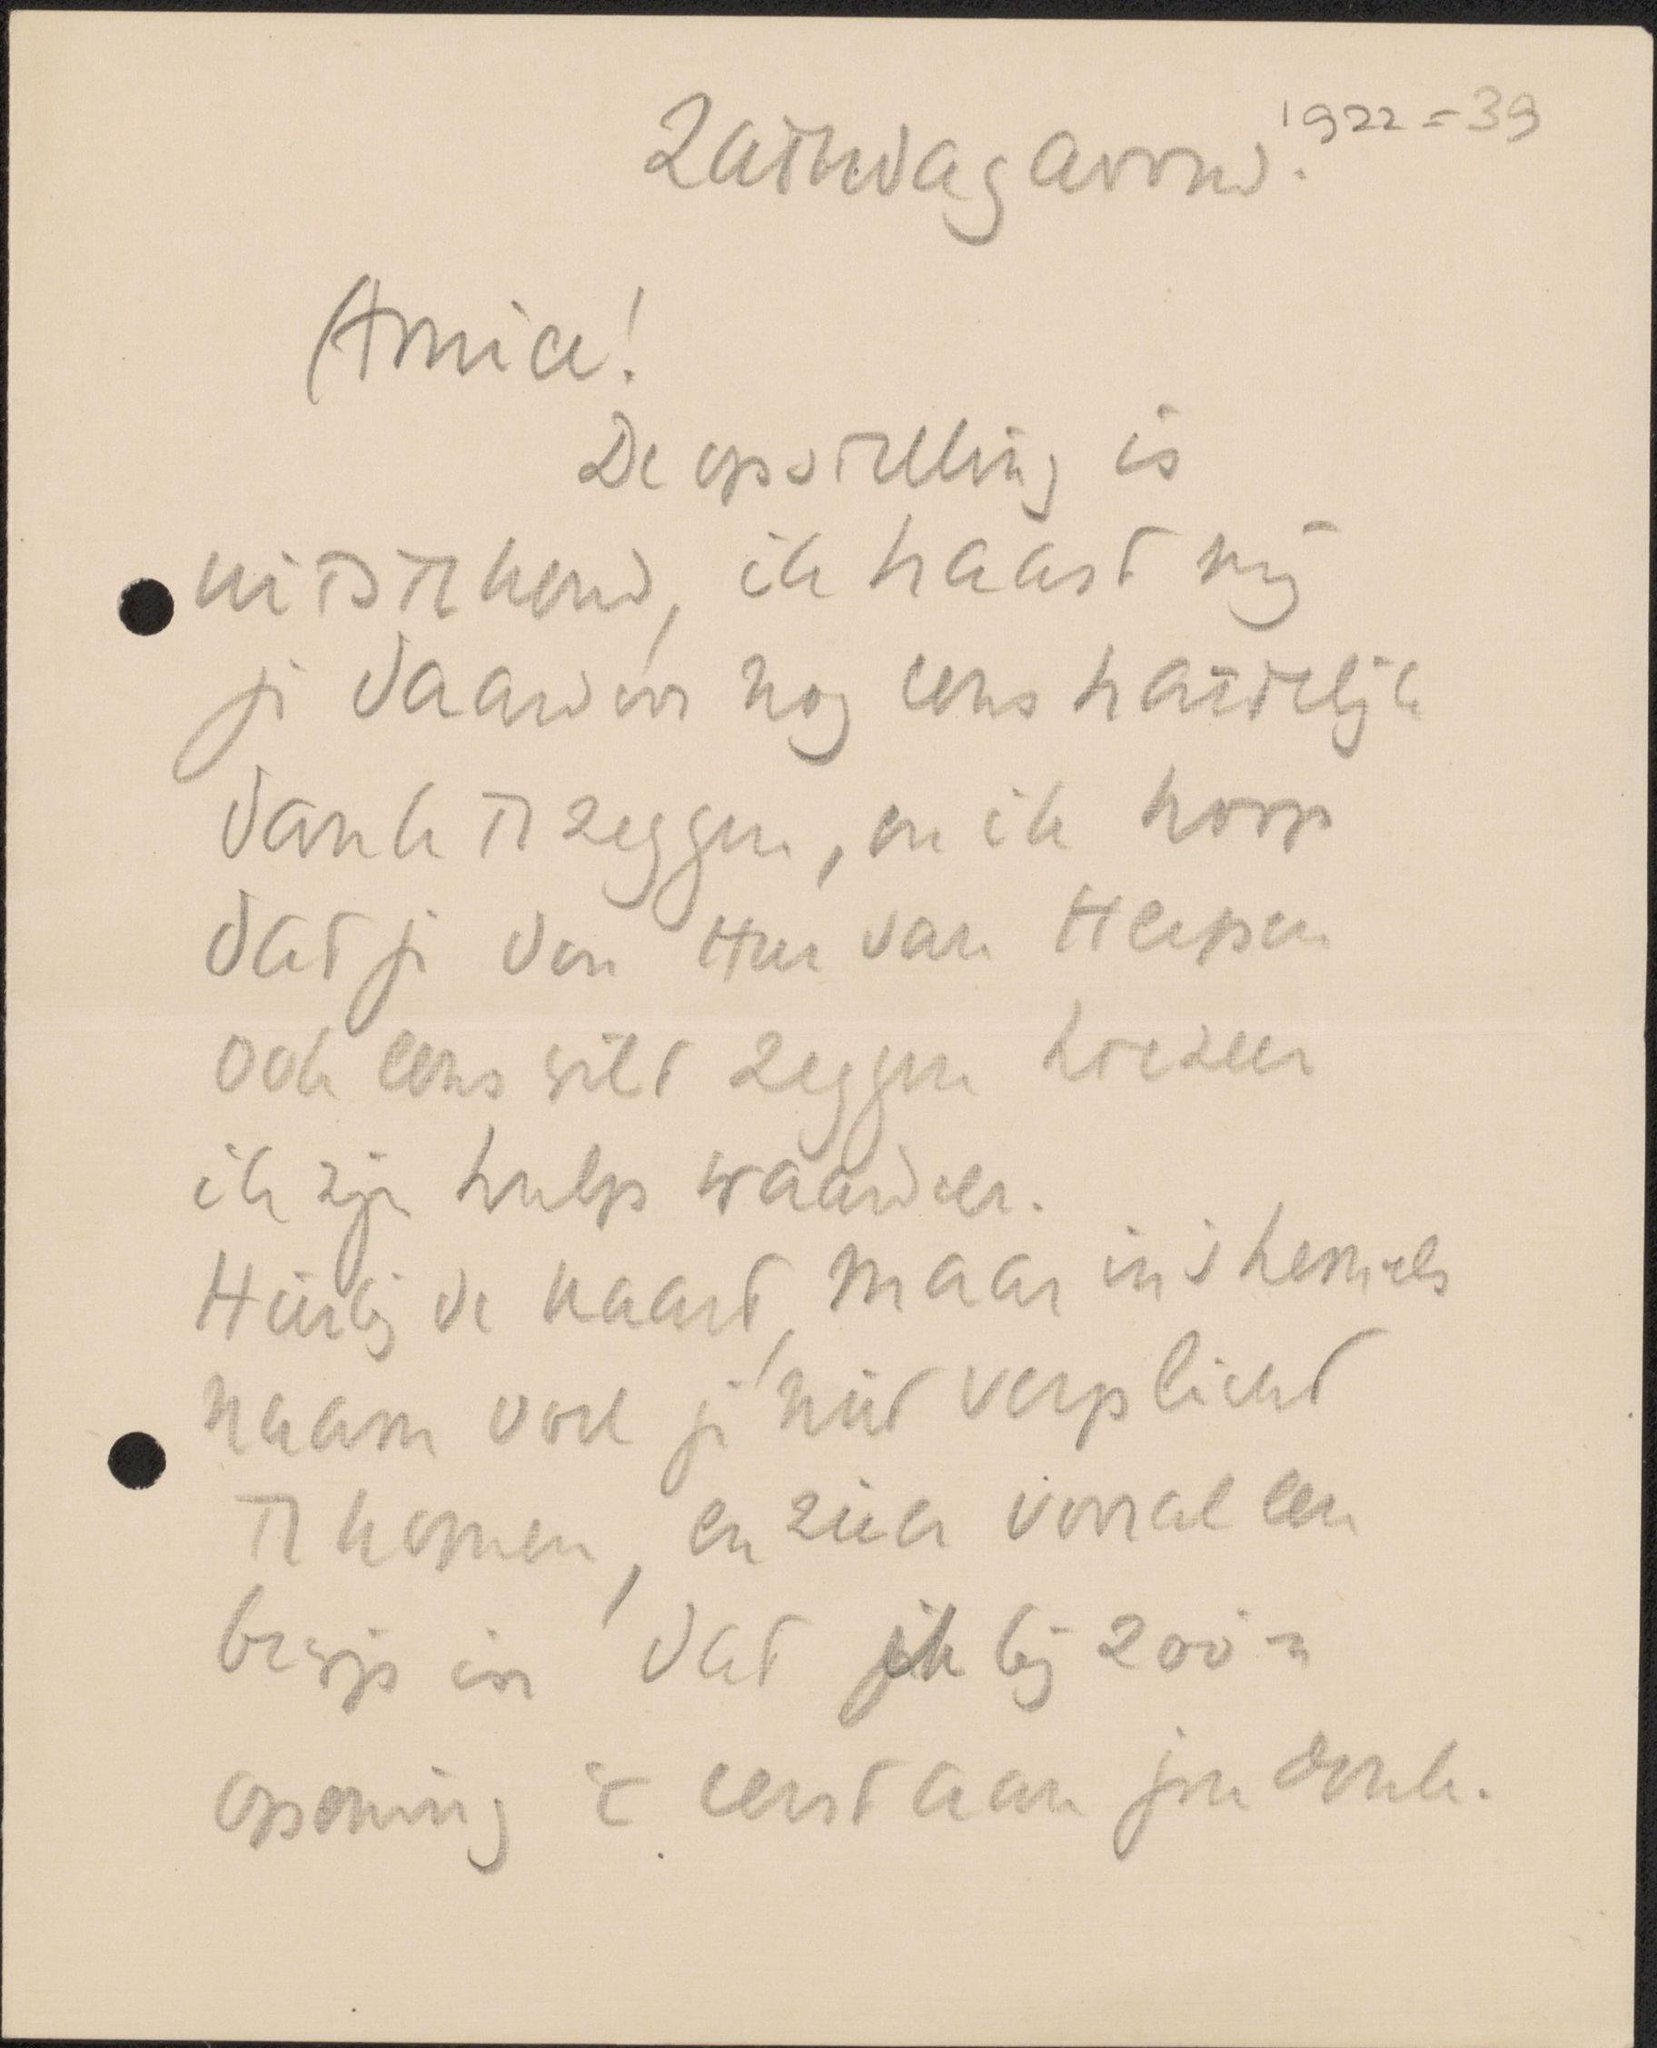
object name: letter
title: Brief aan Willem Bogtman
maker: richard nicolaüs roland holst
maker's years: 1868-1938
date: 1922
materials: paper, pencil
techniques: pen, writing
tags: willem bogtman, exhibition ~ art, money